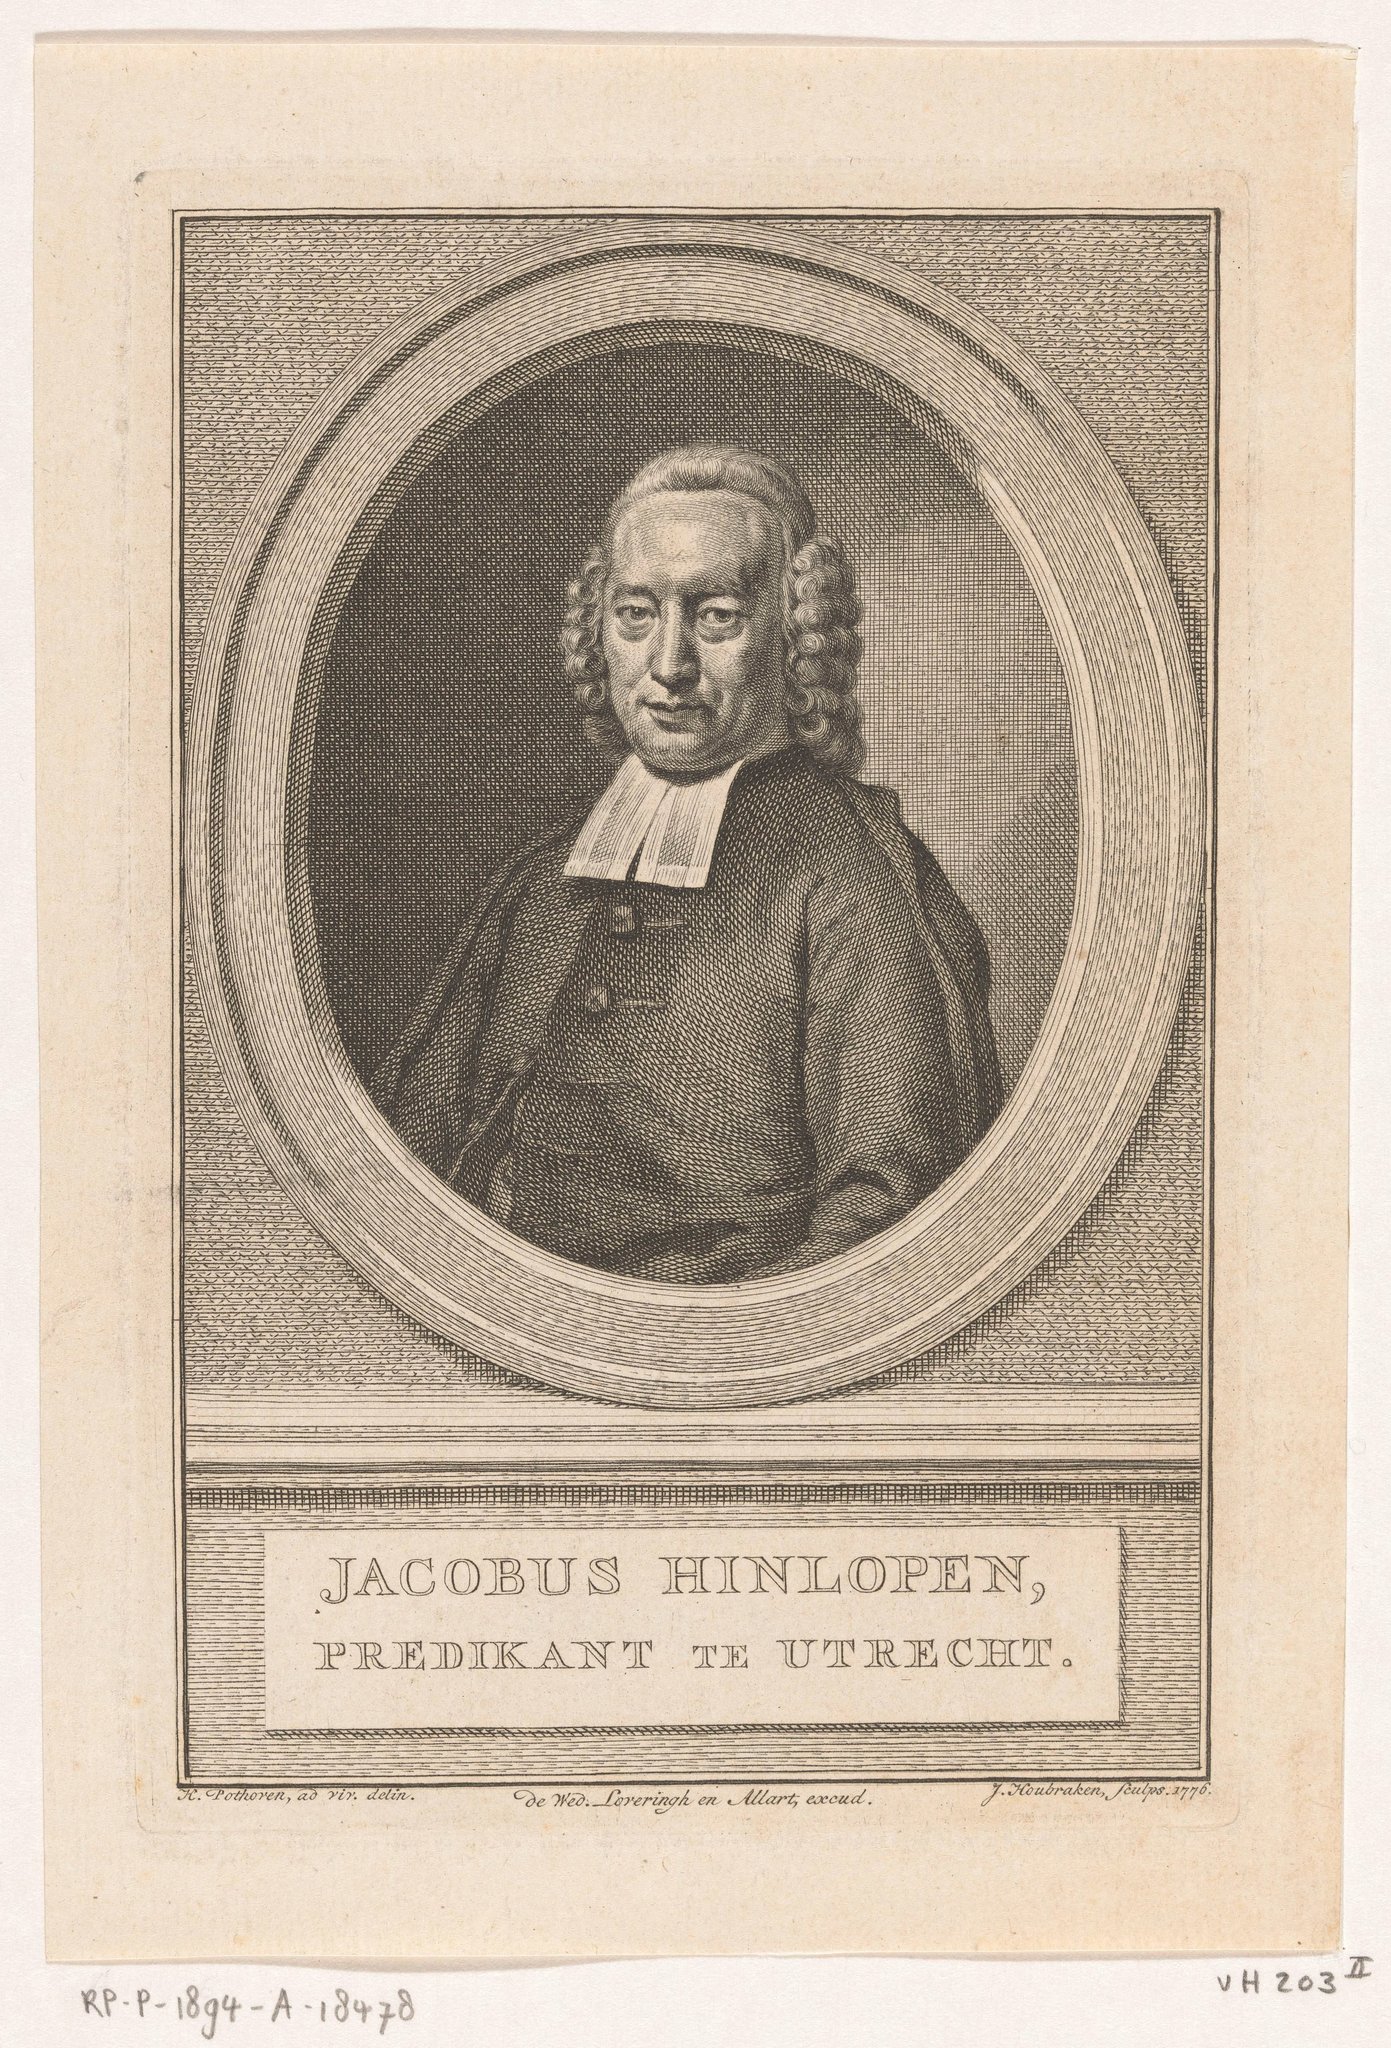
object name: print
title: Jacobus Hinlopen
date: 1776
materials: paper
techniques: engraving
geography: amsterdam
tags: hoorn (north holland), utrecht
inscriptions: collector's mark: Lugt 2228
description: Prent volgens Ver Huell ook gebruikt in: Josua van Iperen, Kerkelyke historie van het psalm-gezang der christenen (...) en inzonderheid van onze verbeterde Nederduitsche psalmberyminge. Amsterdam: wed. Loveringh en Allart, 1777. Deel 2: J. Allart, 1778.